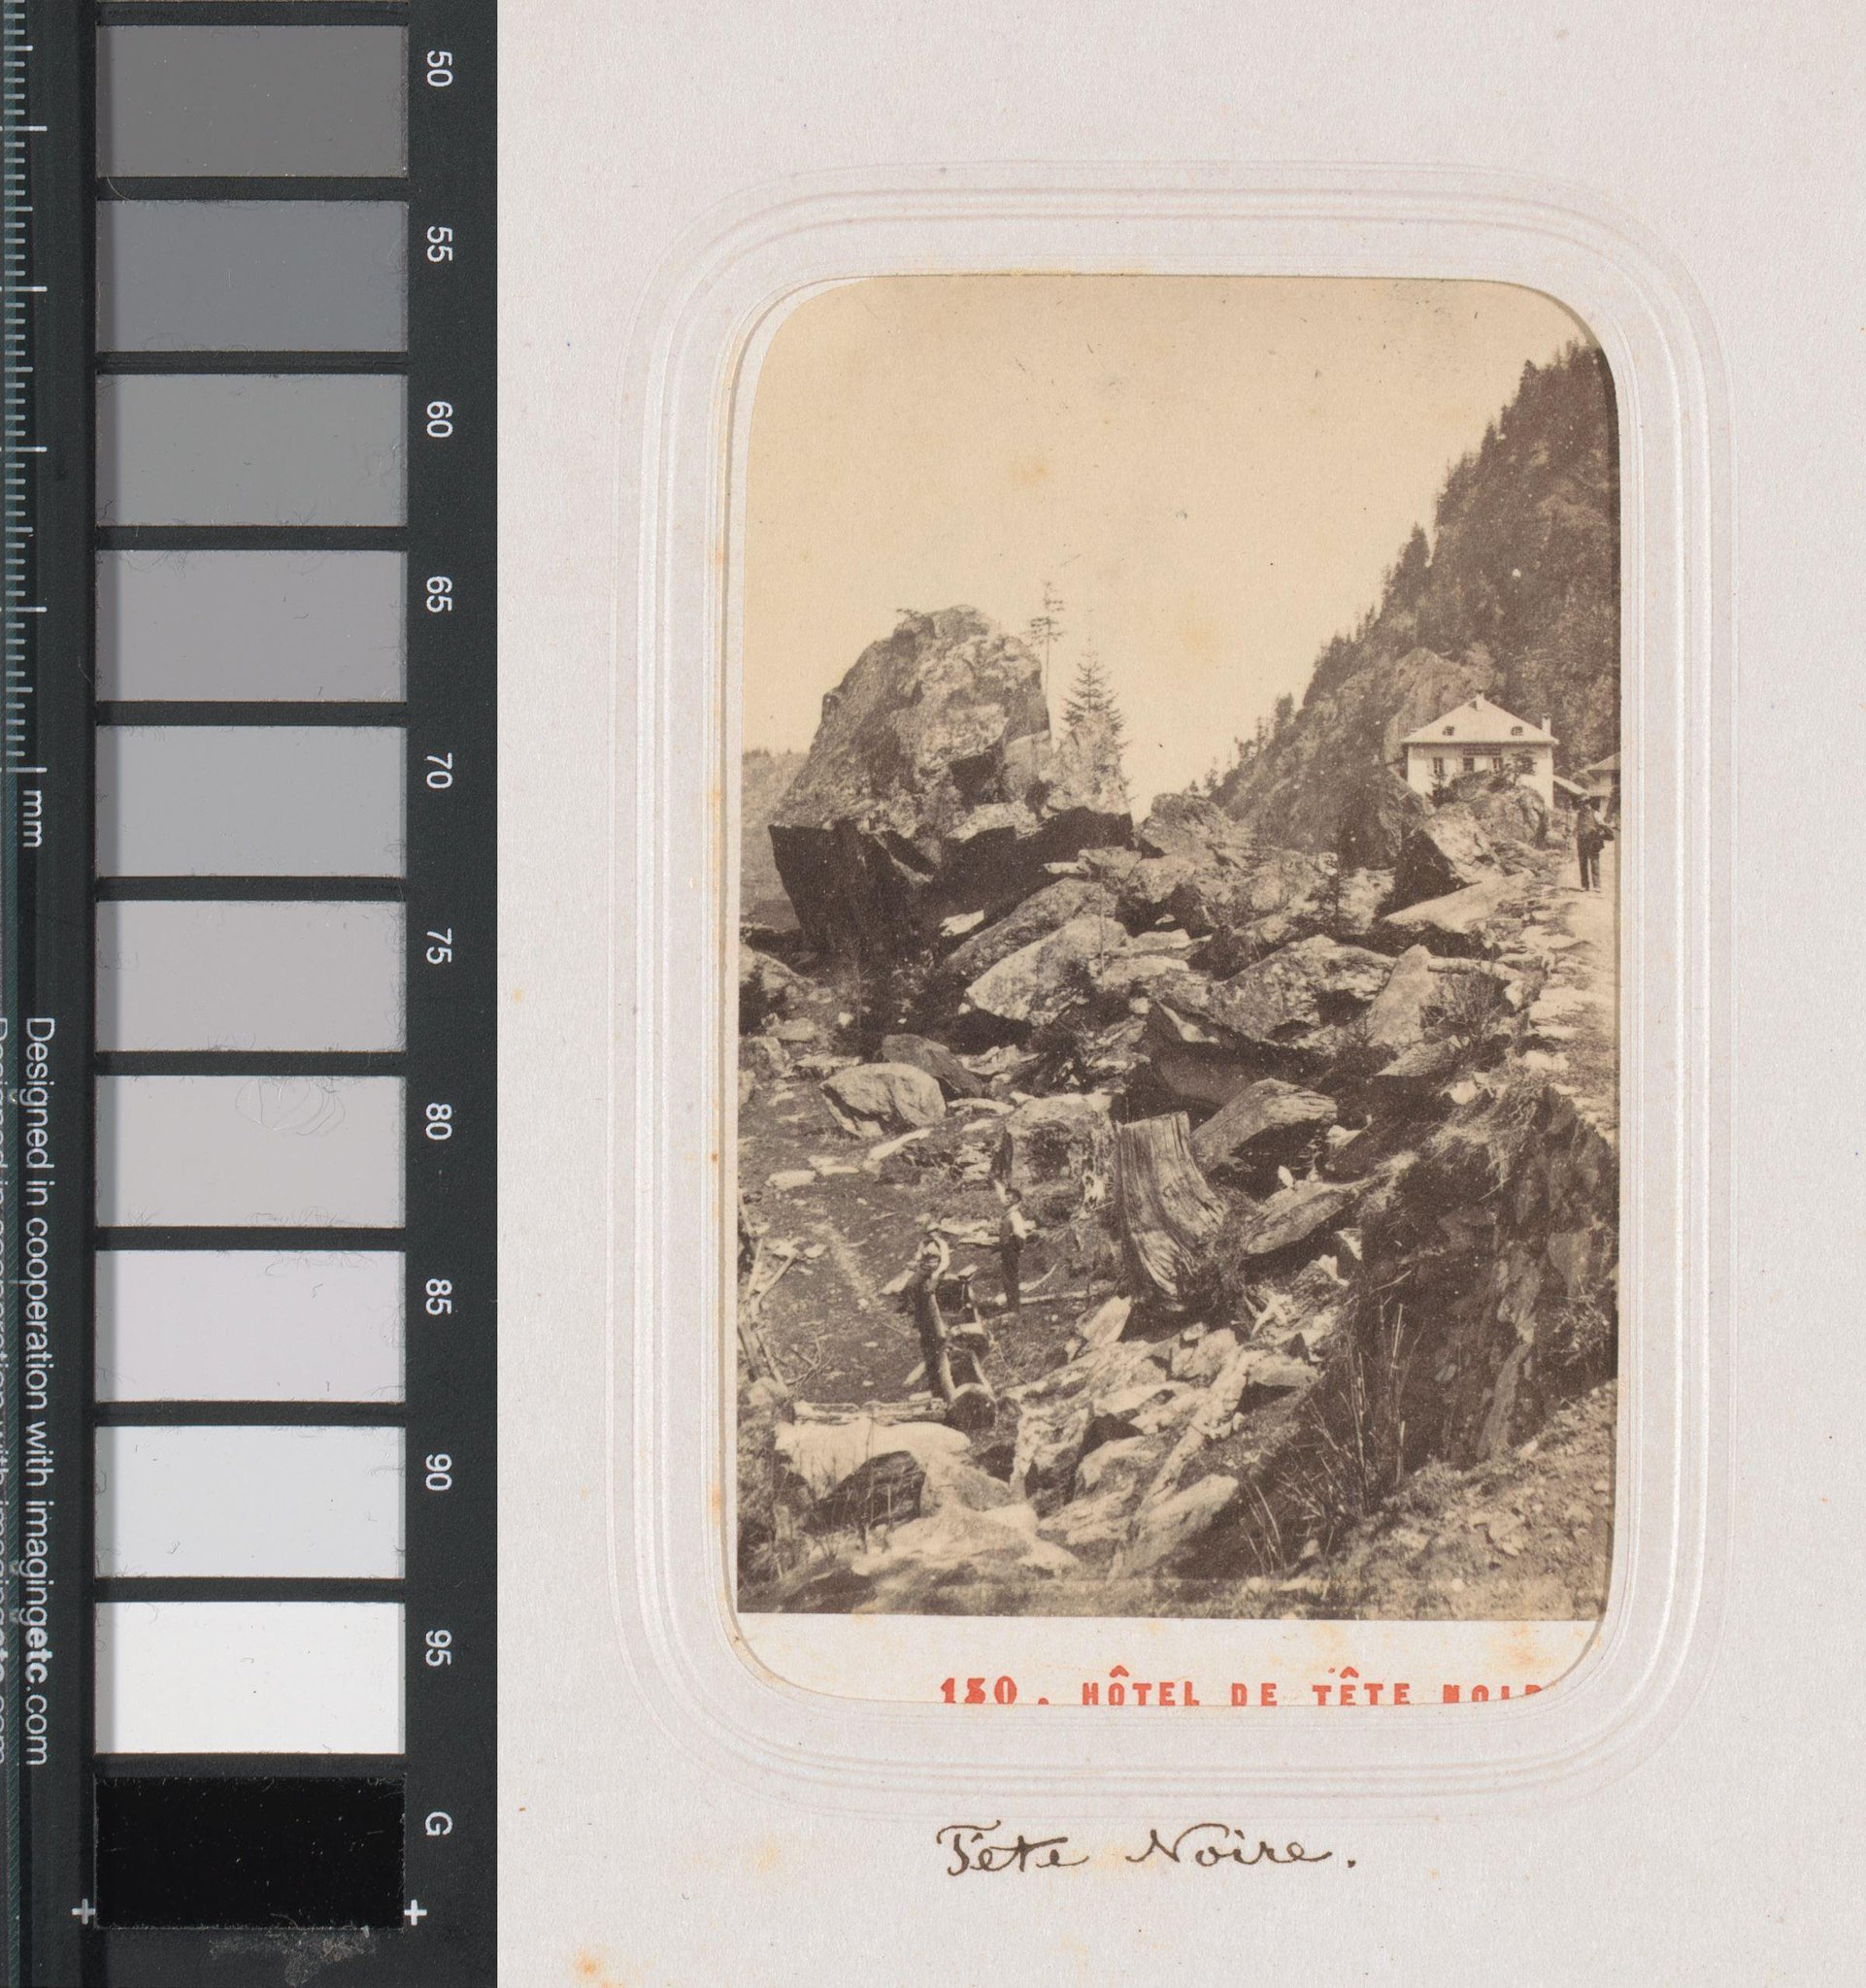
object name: photograph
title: Mannen op een pad bij de Tête Noire in het Wallis, op de achtergrond een hotel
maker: Anonymous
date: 1871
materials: cardboard, paper, photographic support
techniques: albumen print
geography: wallis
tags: rock-formations, hotel, hostelry, inn, mountains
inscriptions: number: ‘150’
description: Onderdeel van Reisalbum met foto's van bezienswaardigheden in Zwitserland.